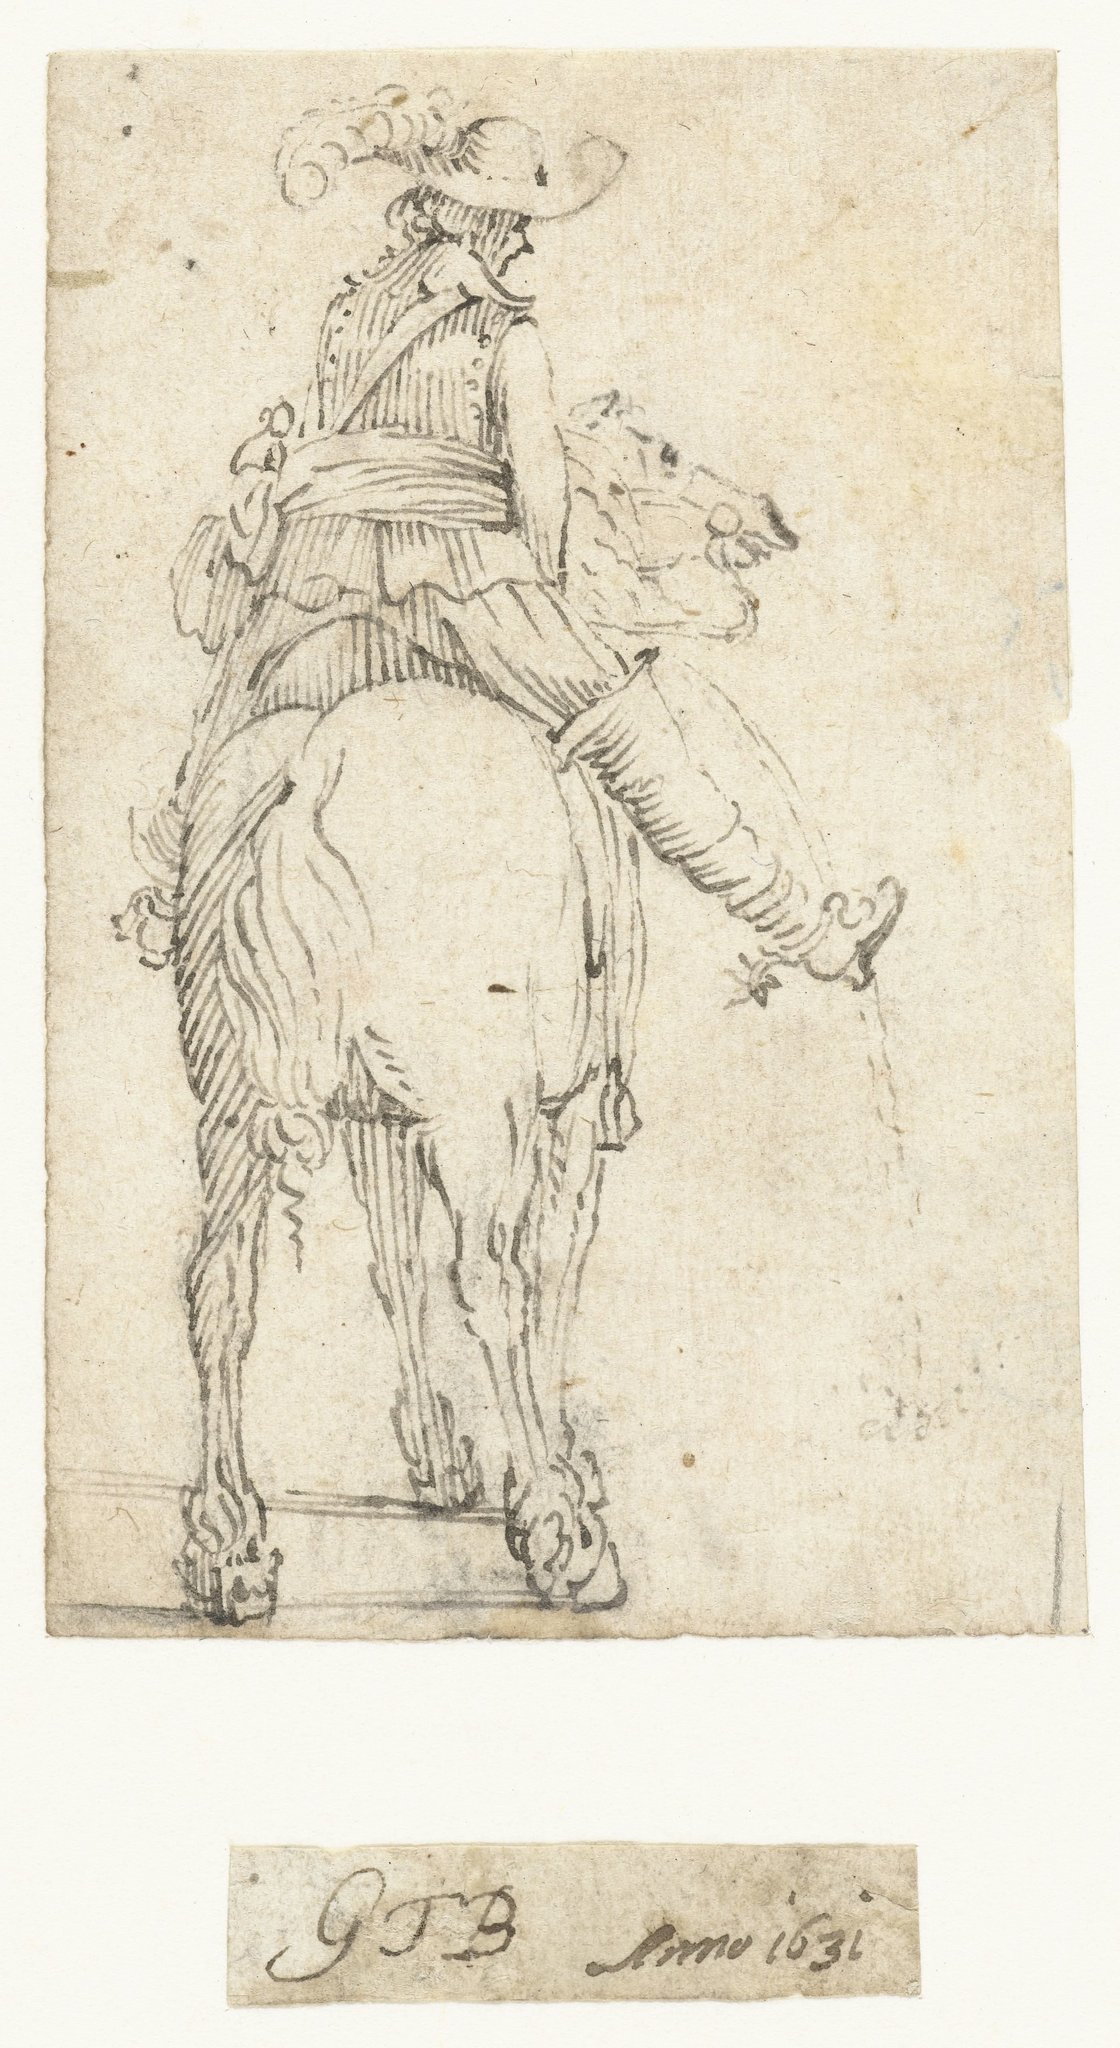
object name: drawing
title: Officier te paard, urinerend, op de rug gezien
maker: gerard ter borch (ii)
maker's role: draughtsman, painter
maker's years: 1617-1681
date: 1631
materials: chalk, ink, paper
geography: amsterdam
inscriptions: monogram and date: ‘GTB Anno 1631’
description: Samen met RP-T-1887-A-787 en los papiertje met monogram en datum op een blad bevestigd.